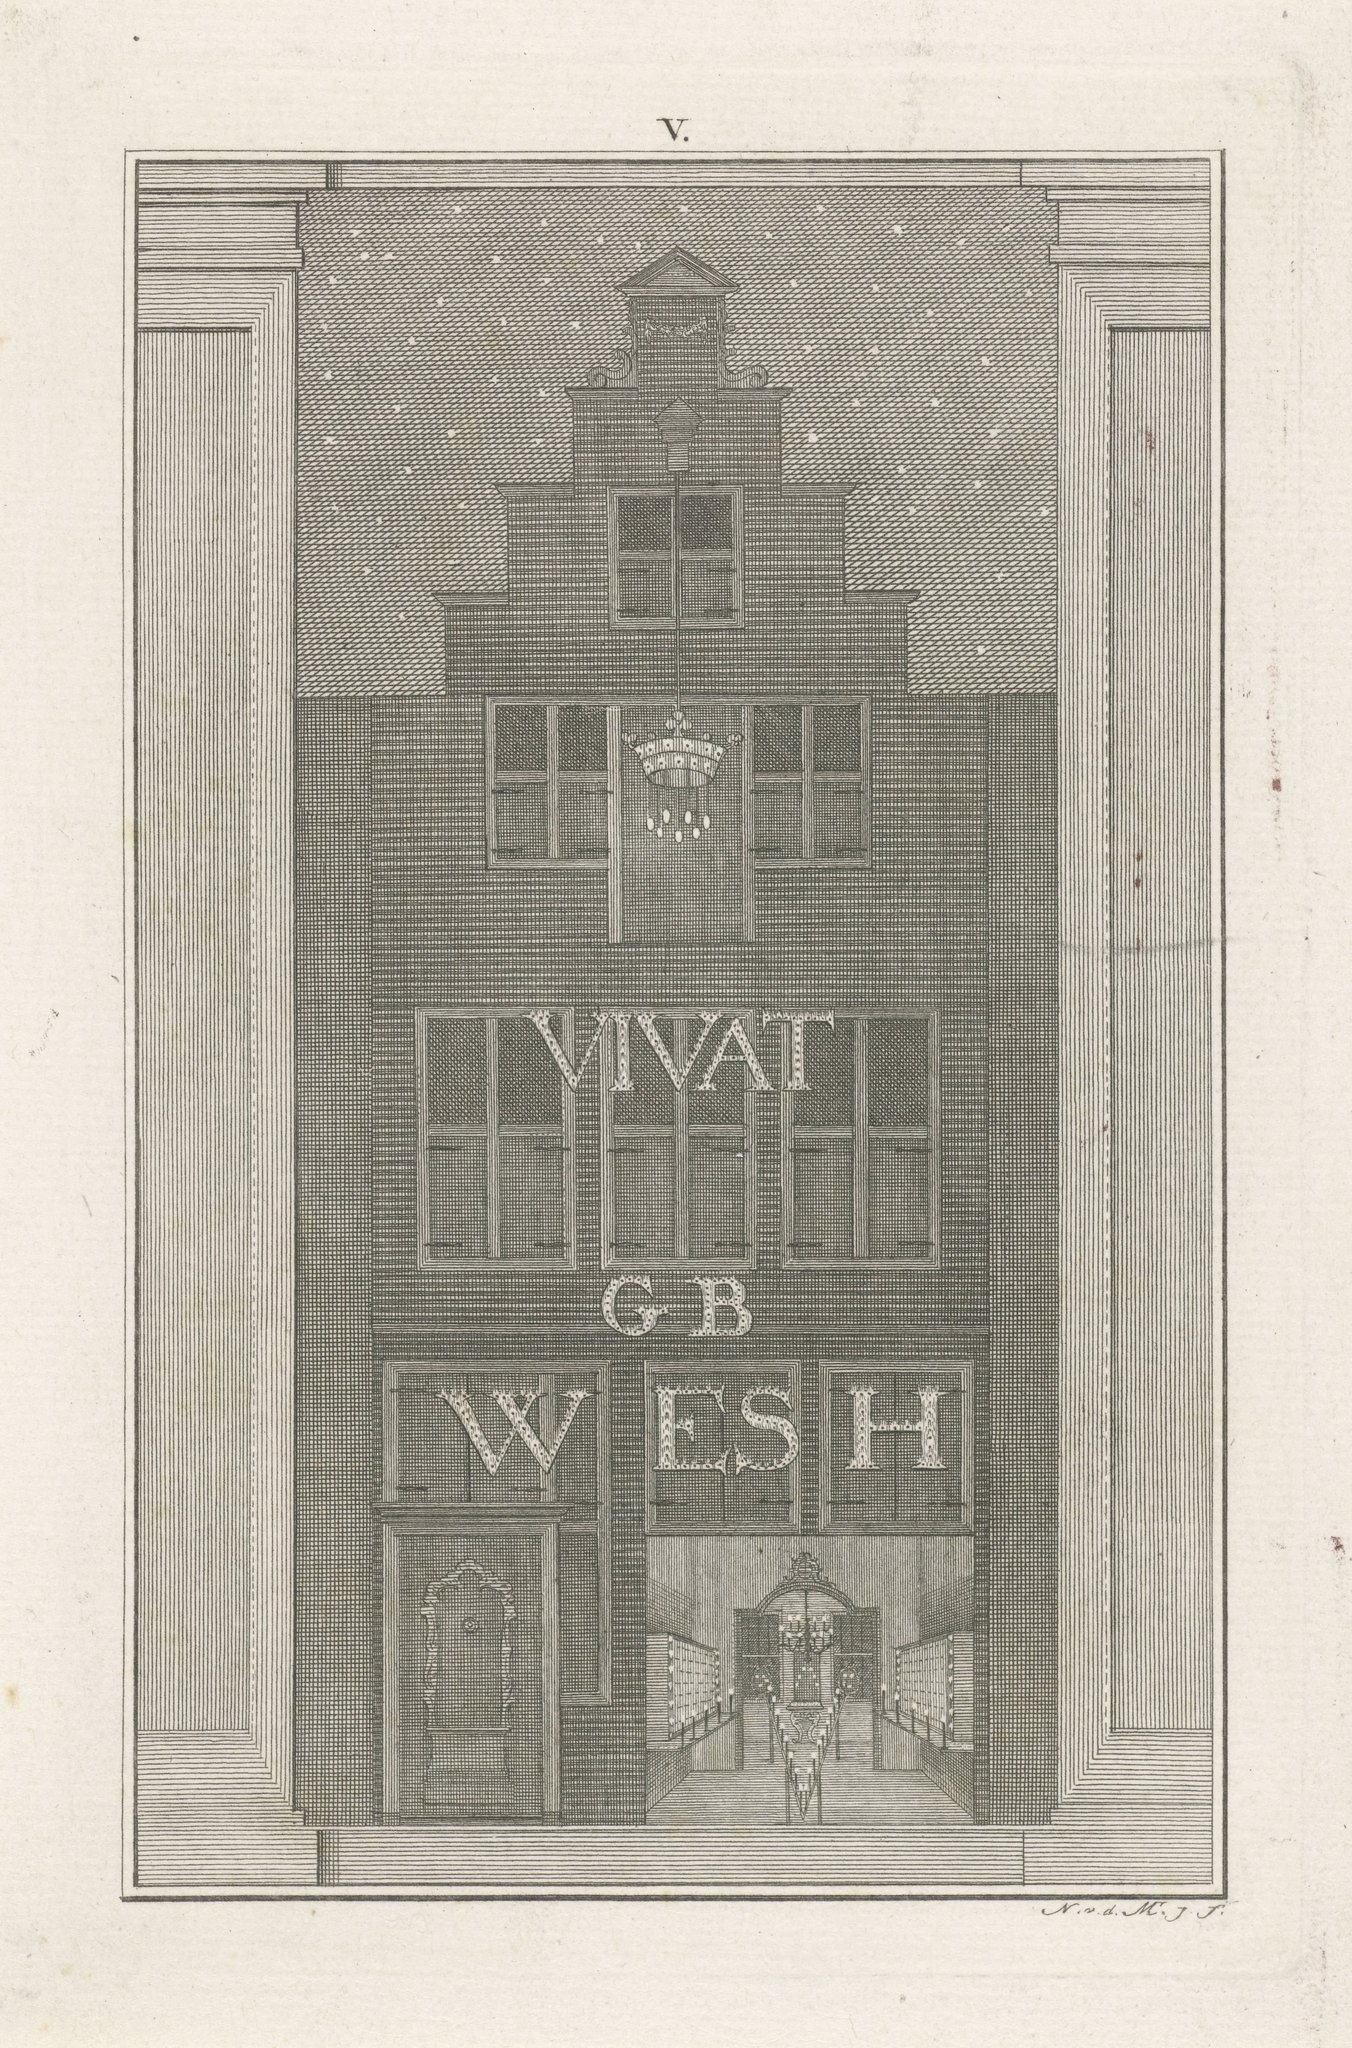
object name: print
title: Verlichting van het huis van de heer Lelijveld op de Herengracht te Leiden, 1766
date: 1776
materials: paper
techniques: etching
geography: amsterdam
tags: the hague, william v (prince of orange), lighting; lamps, front façade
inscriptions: collector's mark: Lugt 2228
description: De illuminatiën van het huis van de heer Willem van Lelijveld op de Herengracht te Leiden op 8 maart 1766 ter gelegenheid van de meerderjarigheid van prins Willem V. Vooraanzicht met opschrift: Vivat GBWESH. Genummerd bovenaan: V.